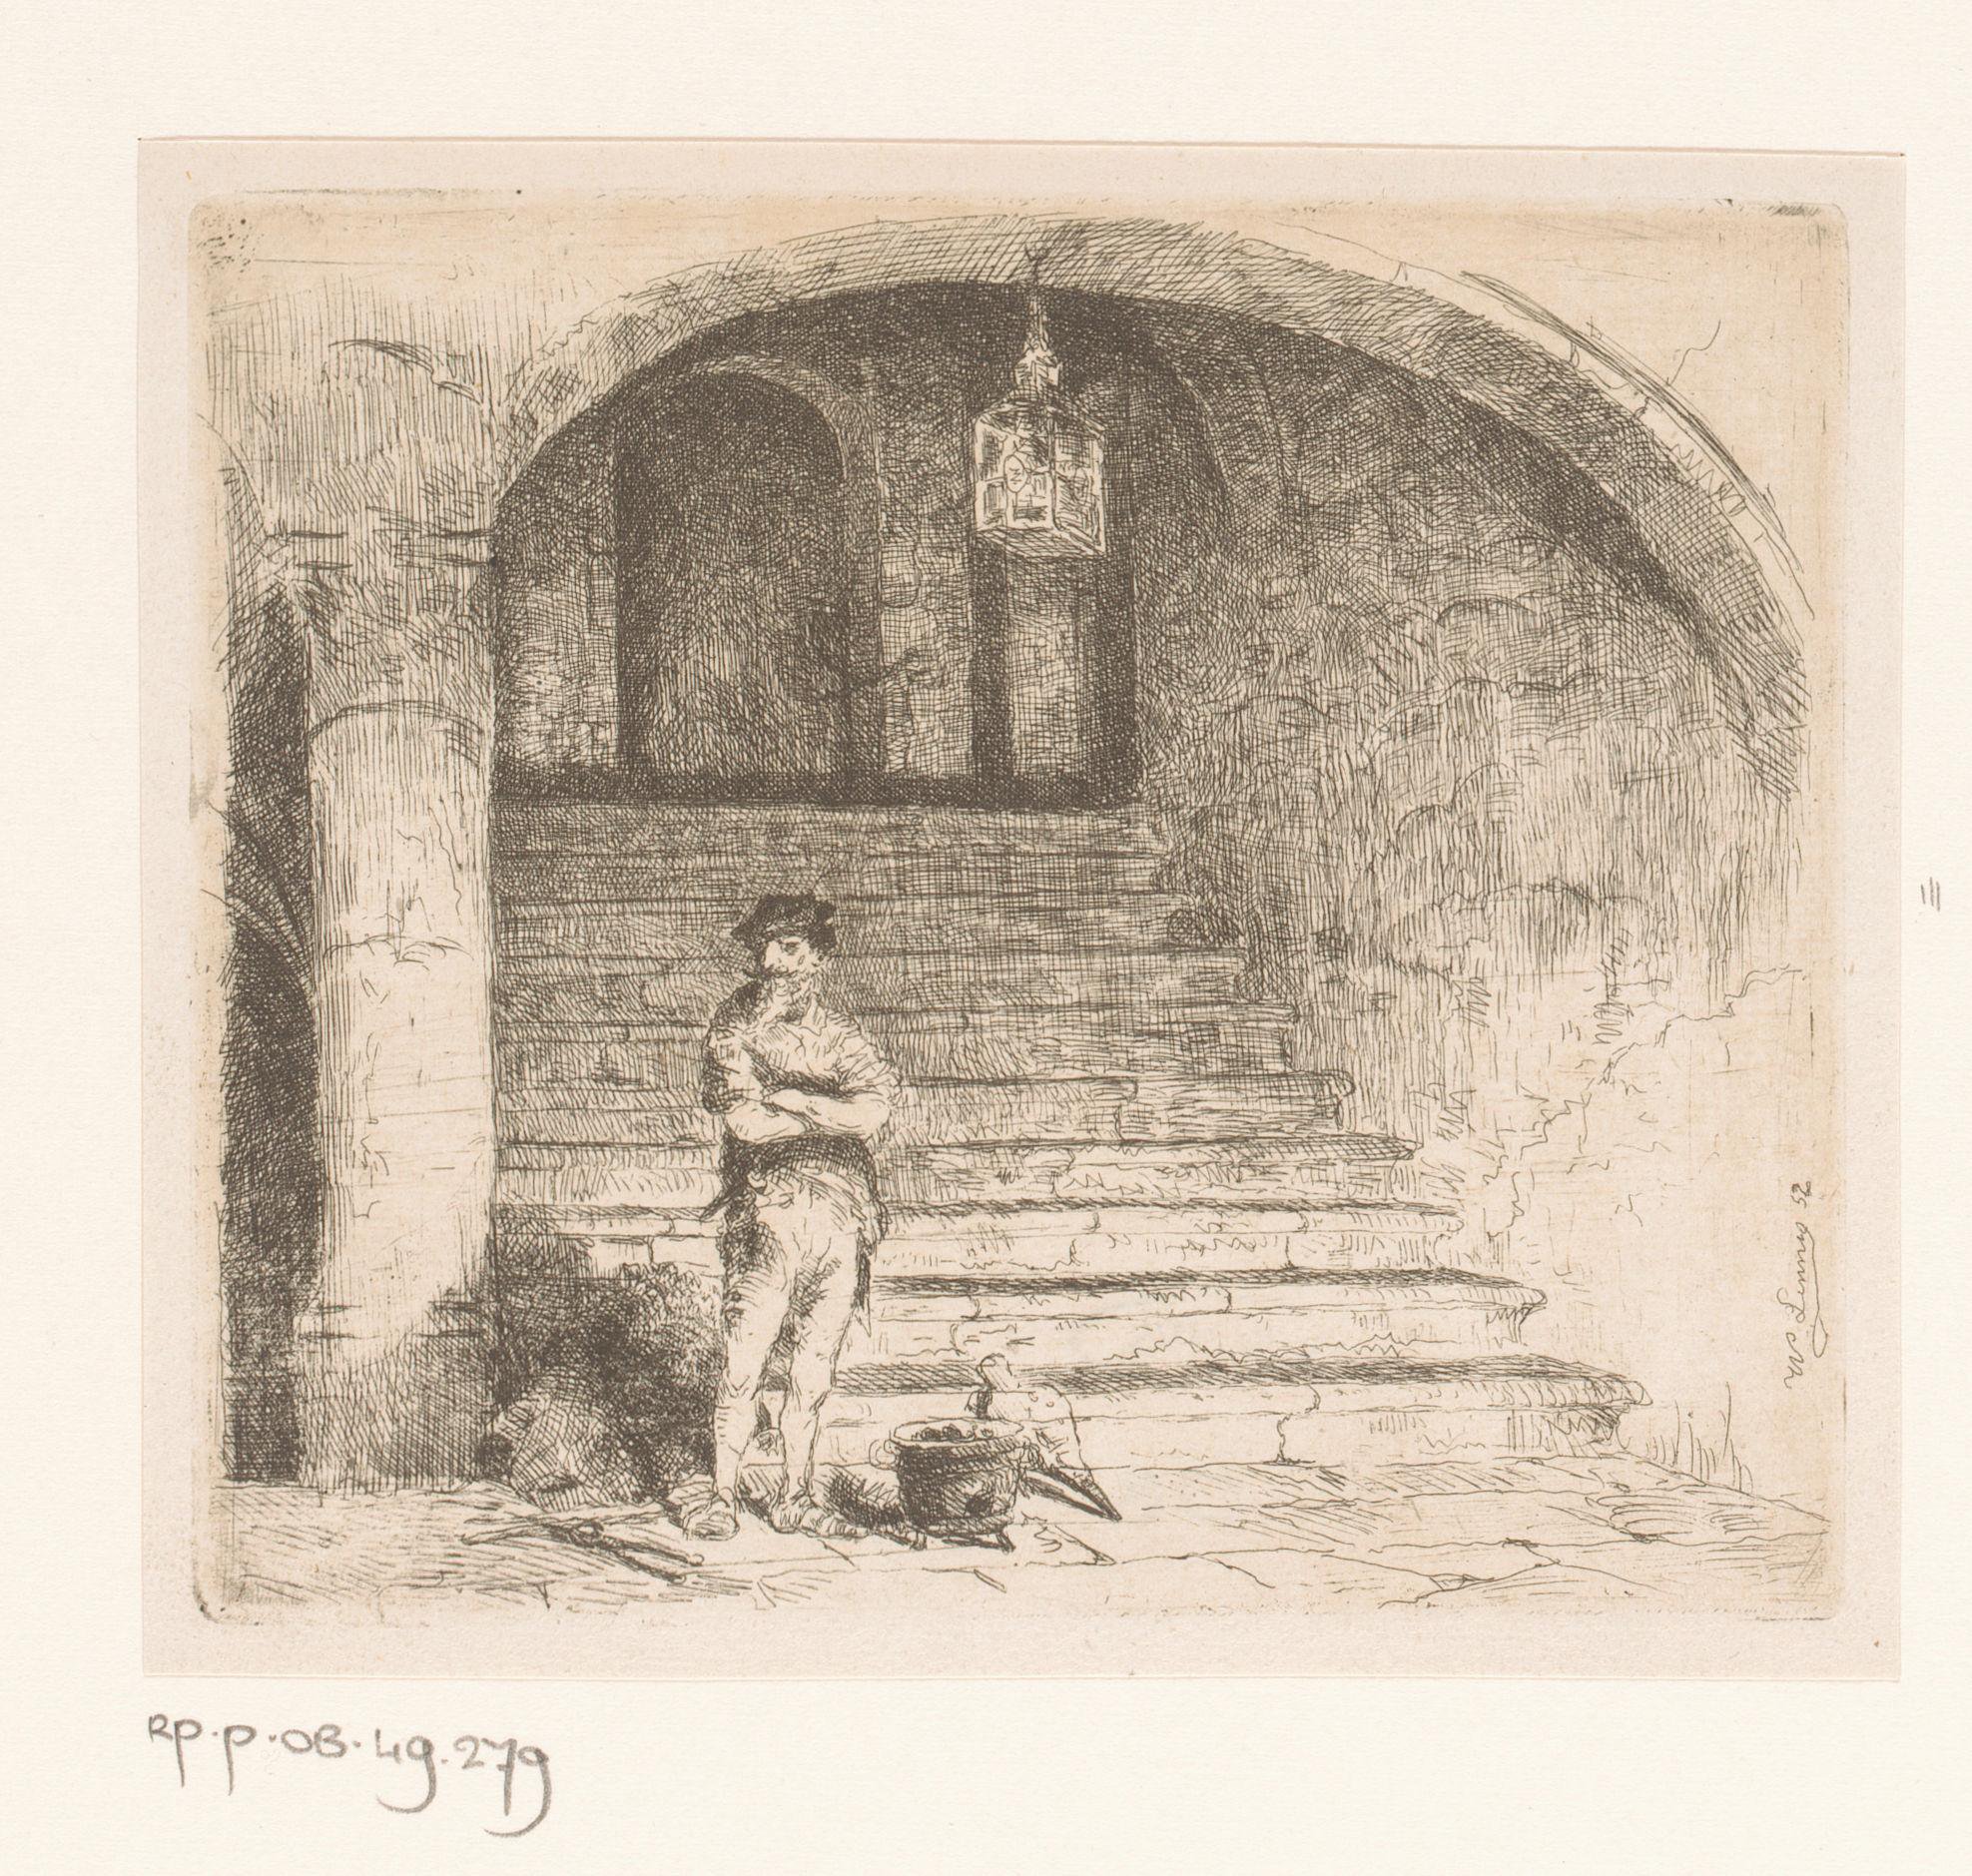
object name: print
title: Man staat naast een ketel bij een trap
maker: willem linnig (i)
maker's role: print maker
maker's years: 1819-1885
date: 1852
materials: paper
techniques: etching, intaglio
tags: adult woman, staircase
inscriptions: collector's mark: Lugt 2228